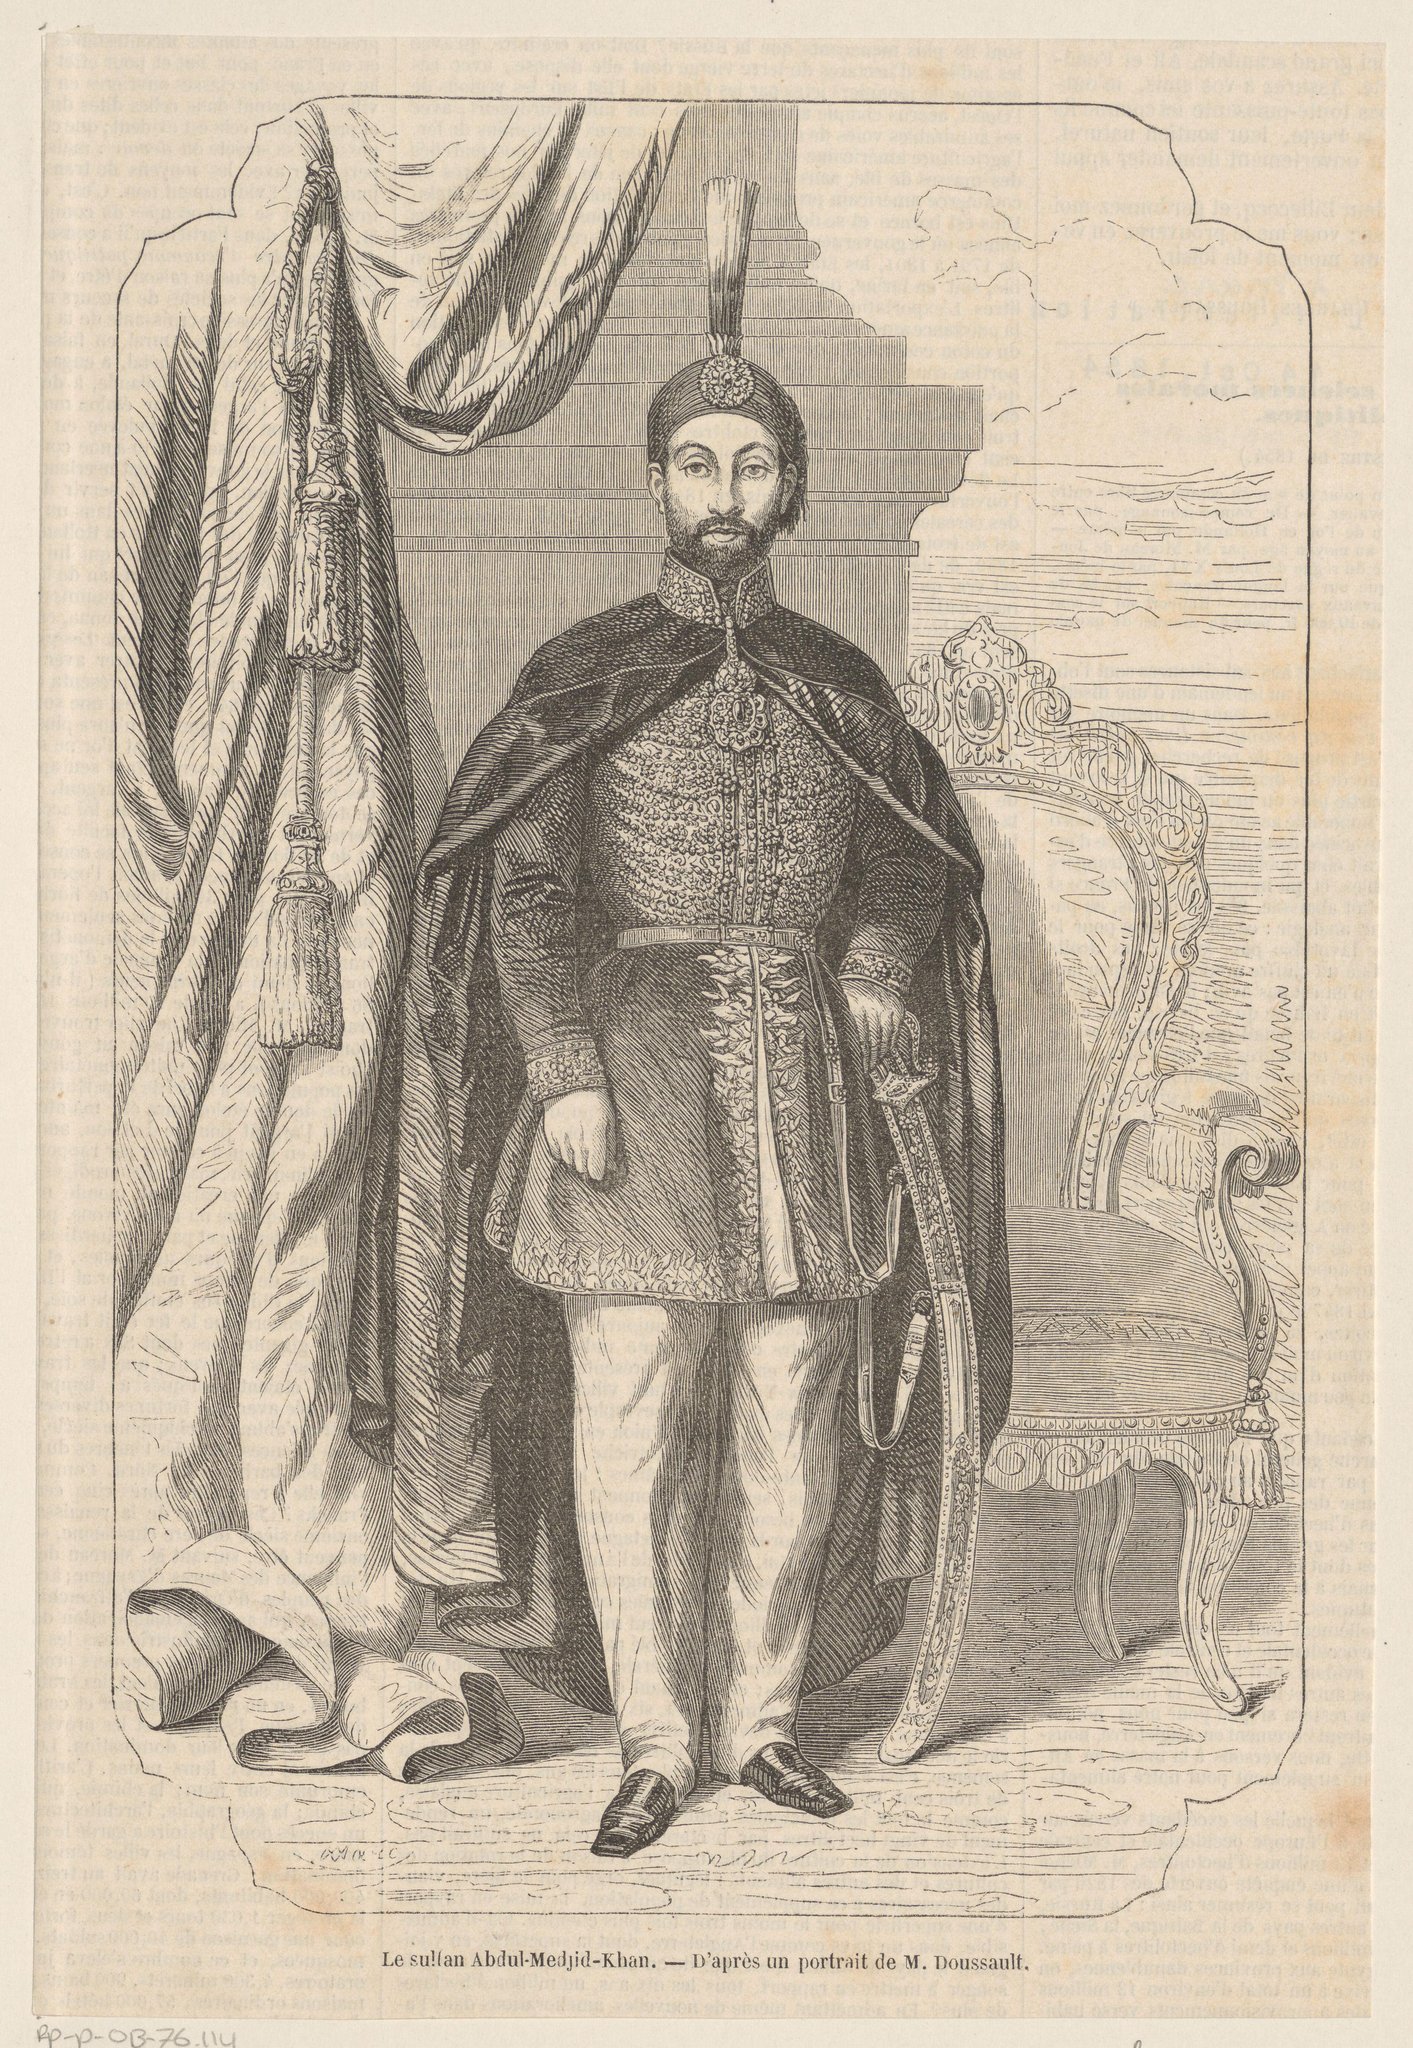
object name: book illustration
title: Portret van Abdülmecit I, sultan van het Ottomaanse Rijk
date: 1854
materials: paper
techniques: letterpress printing, engraving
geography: france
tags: constantinopel, sultan, abdülmecit i (sultan van het ottomaanse rijk)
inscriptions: stamp: ‘JVB’, stamp: ‘L'Illustration 14 Oct, 1854’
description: Portret van Abdülmecit I. Hij staat voor een troon en naast een draperie. In de ondermarge zijn naam en titel in boekdruk.